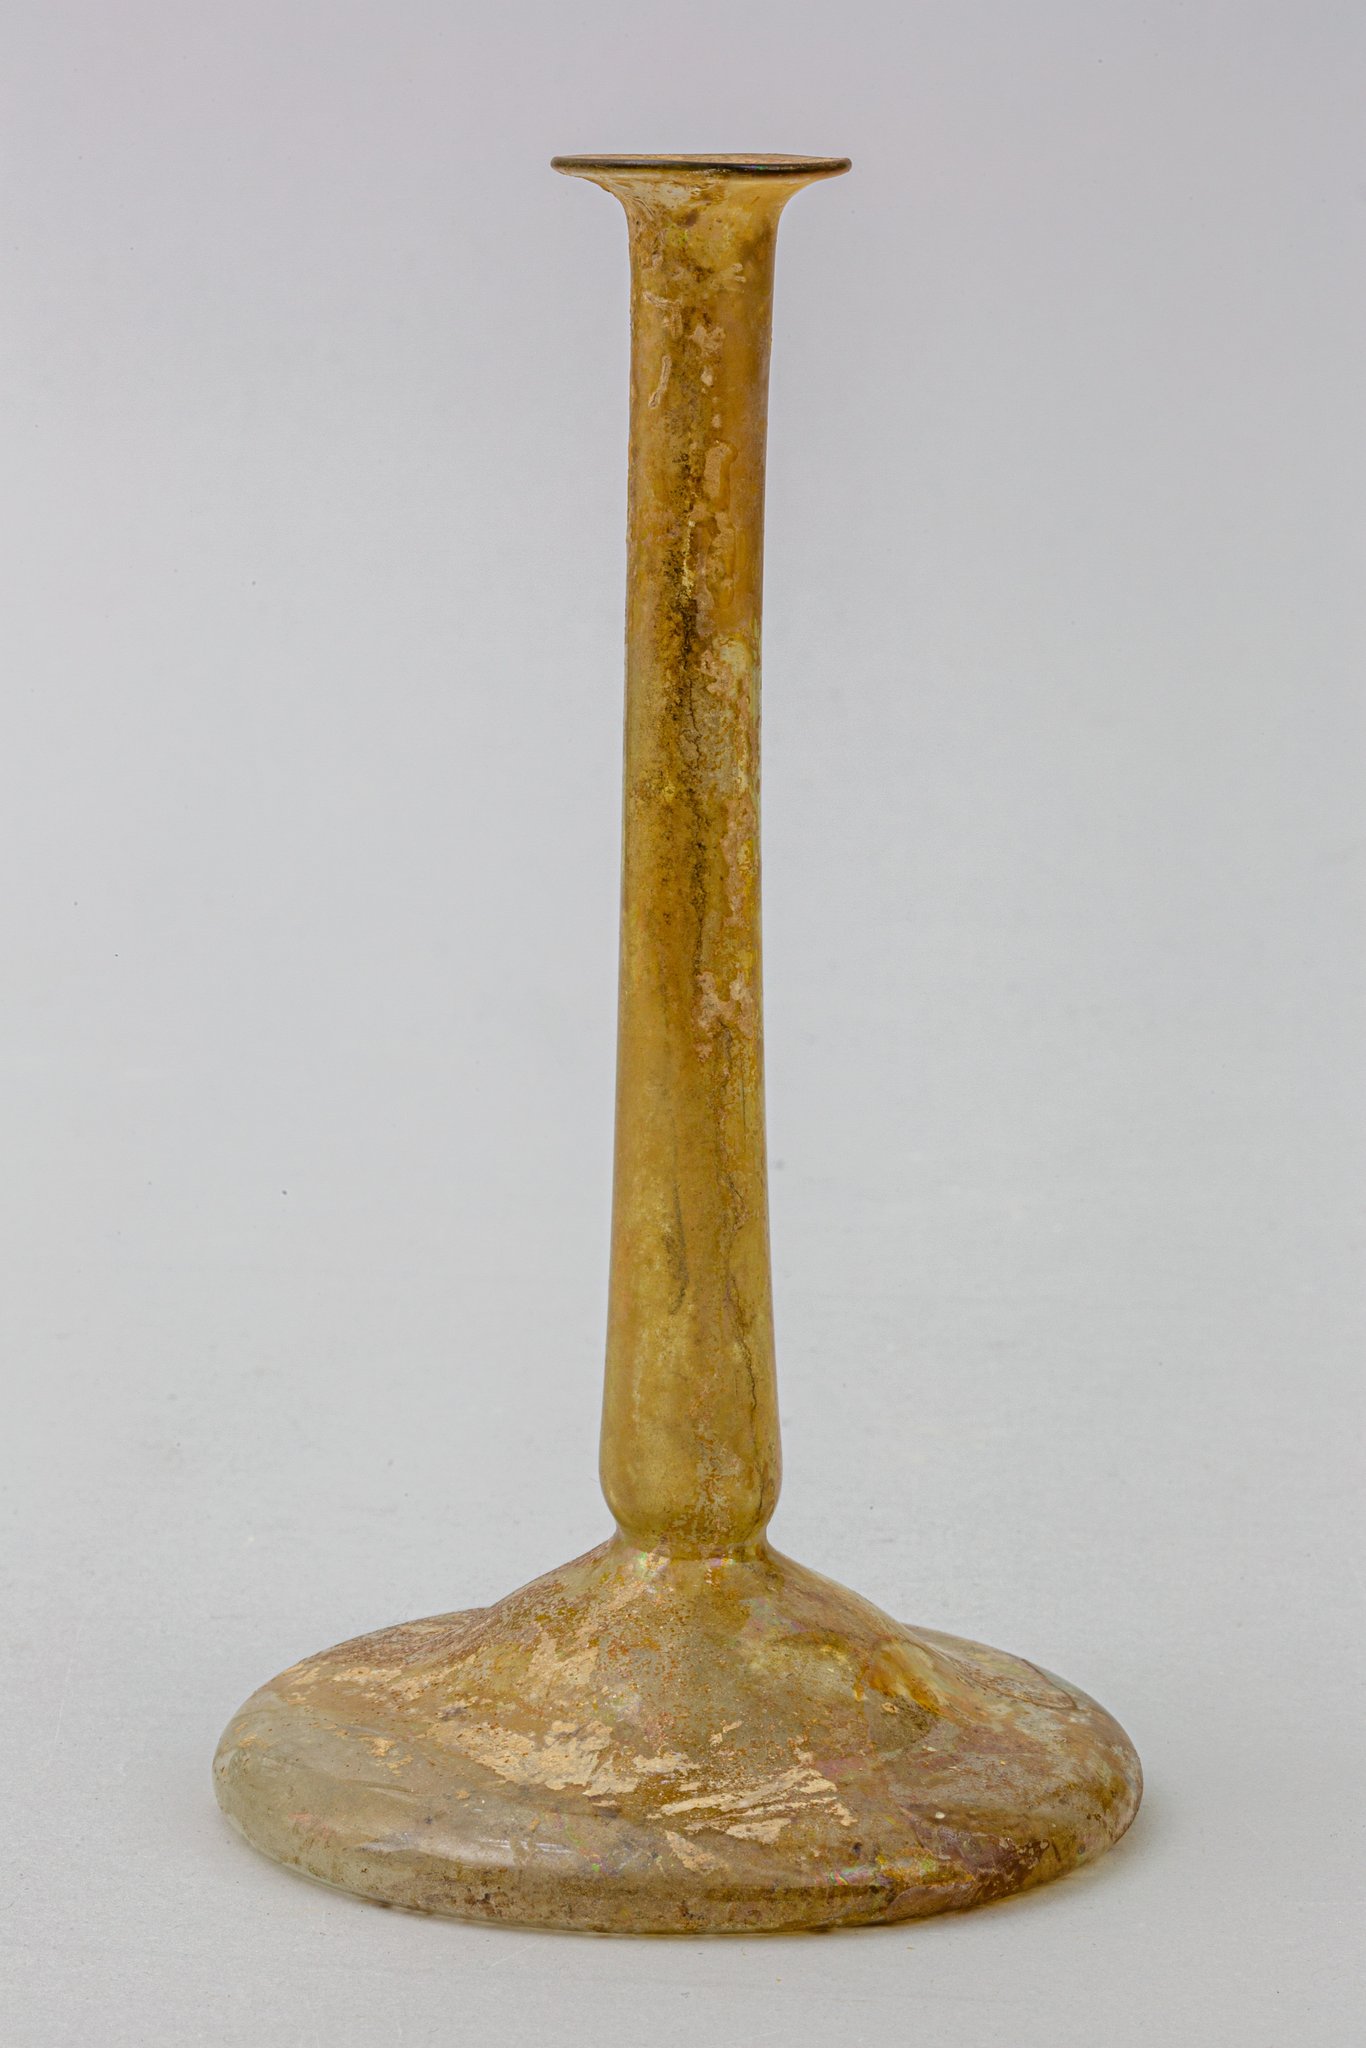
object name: candlestick perfume bottle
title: Glass perfume bottle (candlestick unguentarium)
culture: roman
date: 101-300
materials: glass